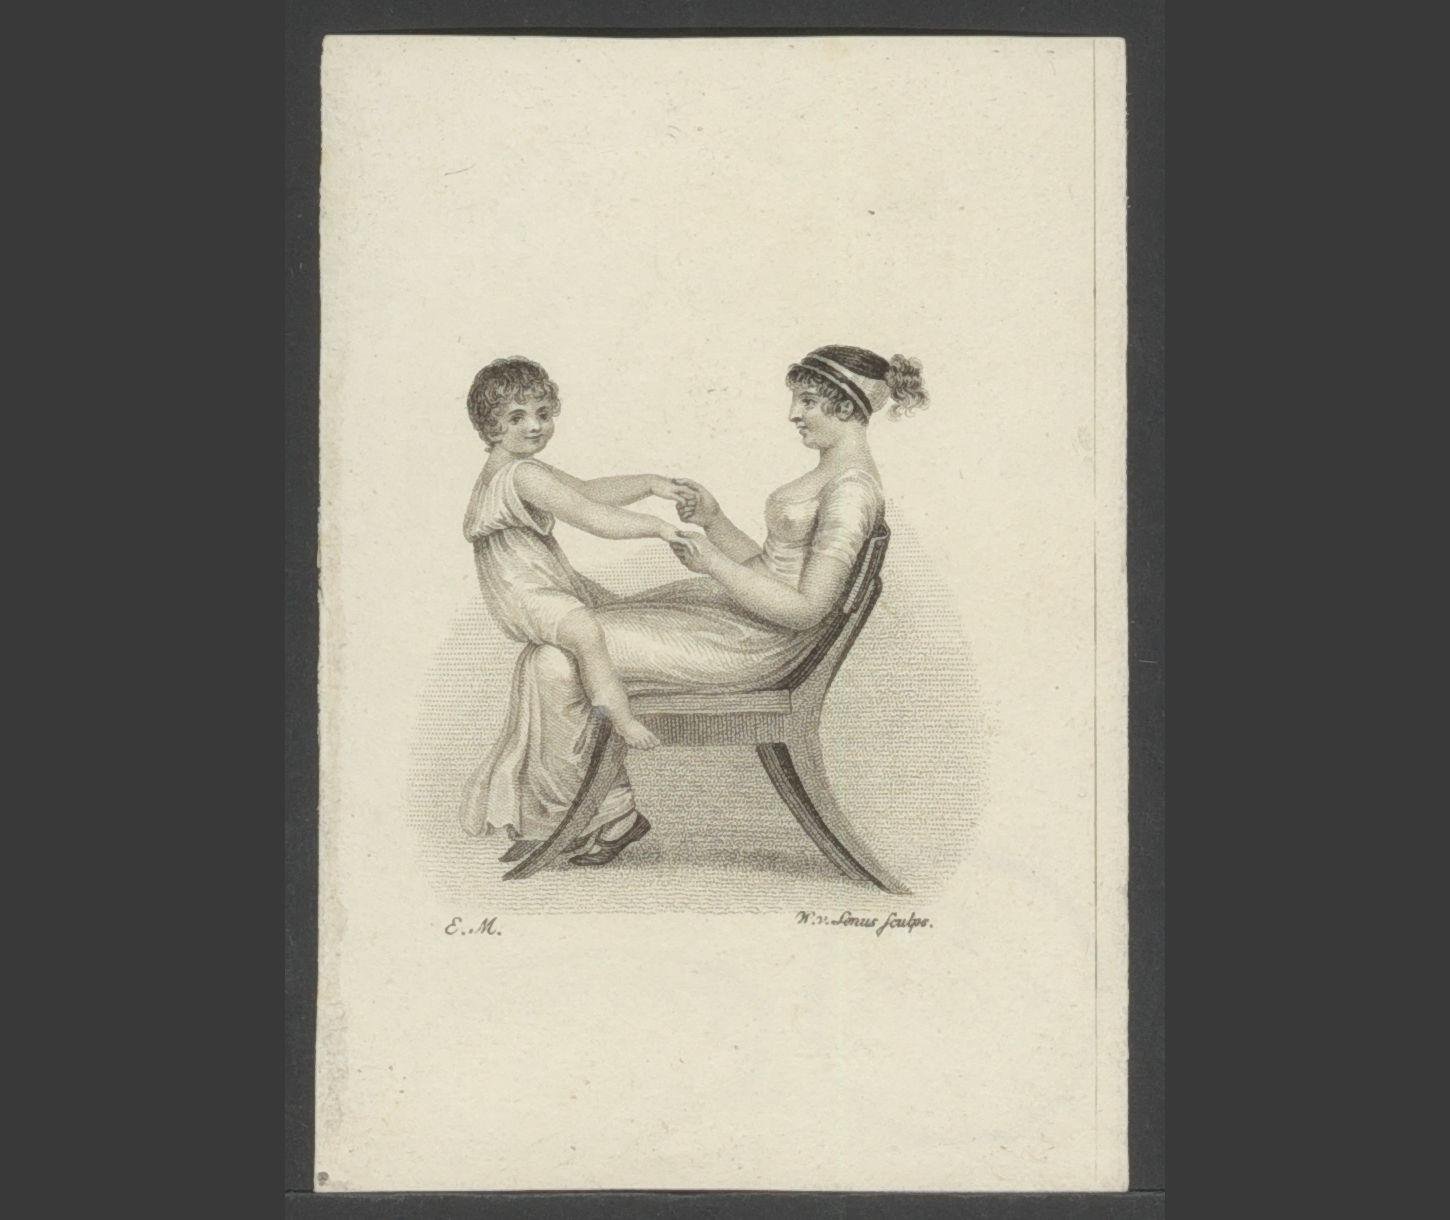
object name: print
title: Zittende vrouw met een kind op haar knieën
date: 1787-1834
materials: paper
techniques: engraving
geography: amsterdam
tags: child, sitting in someone's lap, sitting on an elevation - aa - female human figure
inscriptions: collector's mark: Lugt 1641, stamp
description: Onderwerpsrubrieken binnen de Atlas Zeden en Gewoonten: Schoone kunsten, Varia.